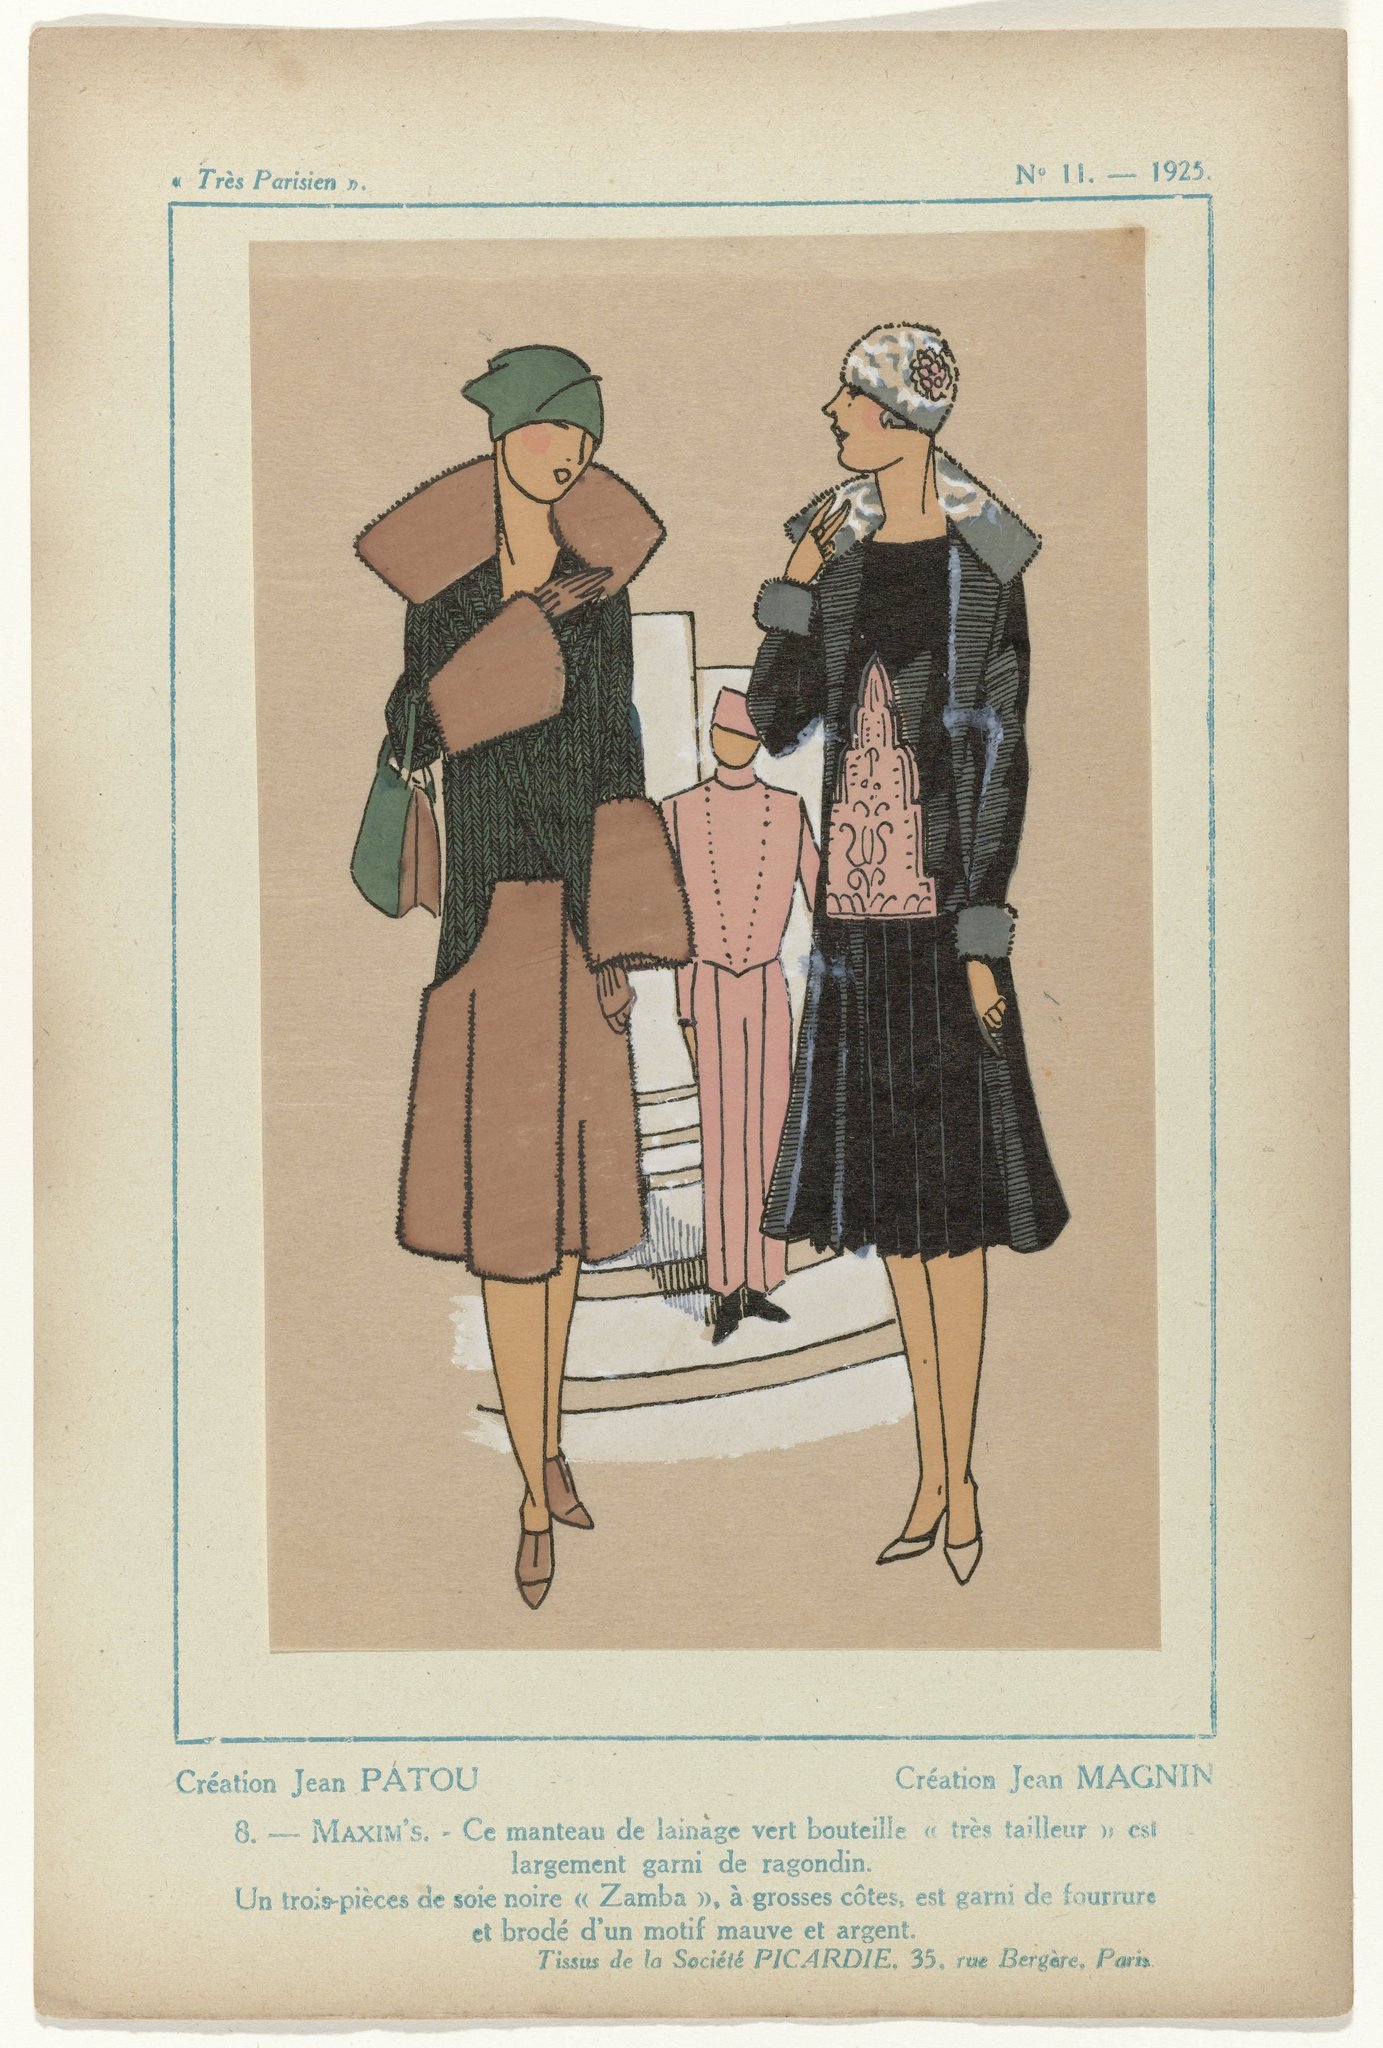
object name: fashion print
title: Très Parisien, 1925, No. 11, Pl. 8: Création Jean PATOU - MAXIM'S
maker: g-p. joumard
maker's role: publisher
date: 1925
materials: paper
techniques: hand coloring, letterpress printing, lithography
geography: paris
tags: ensembles of pieces of clothing (three piece suit) (+ women's clothes), fashion plates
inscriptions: caption: ‘8. - MAXIM'S. - Ce manteau de lainage vert bouteill "très tailleur" est largement garni de ragondin. Un trois-pièces de soie noire "Zamba" à grosses côtes, est garni de fourrure et brodé d'un motif mauve et argent.’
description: Mantel van Jean Patou. Driedelig ensemble van Jean Magnin. De stoffen zijn van de Société Picardie, Parijs. Prent uit het modetijdschrift Très Parisien...La Mode, Le Chic, L'Élégance (1920-1936)